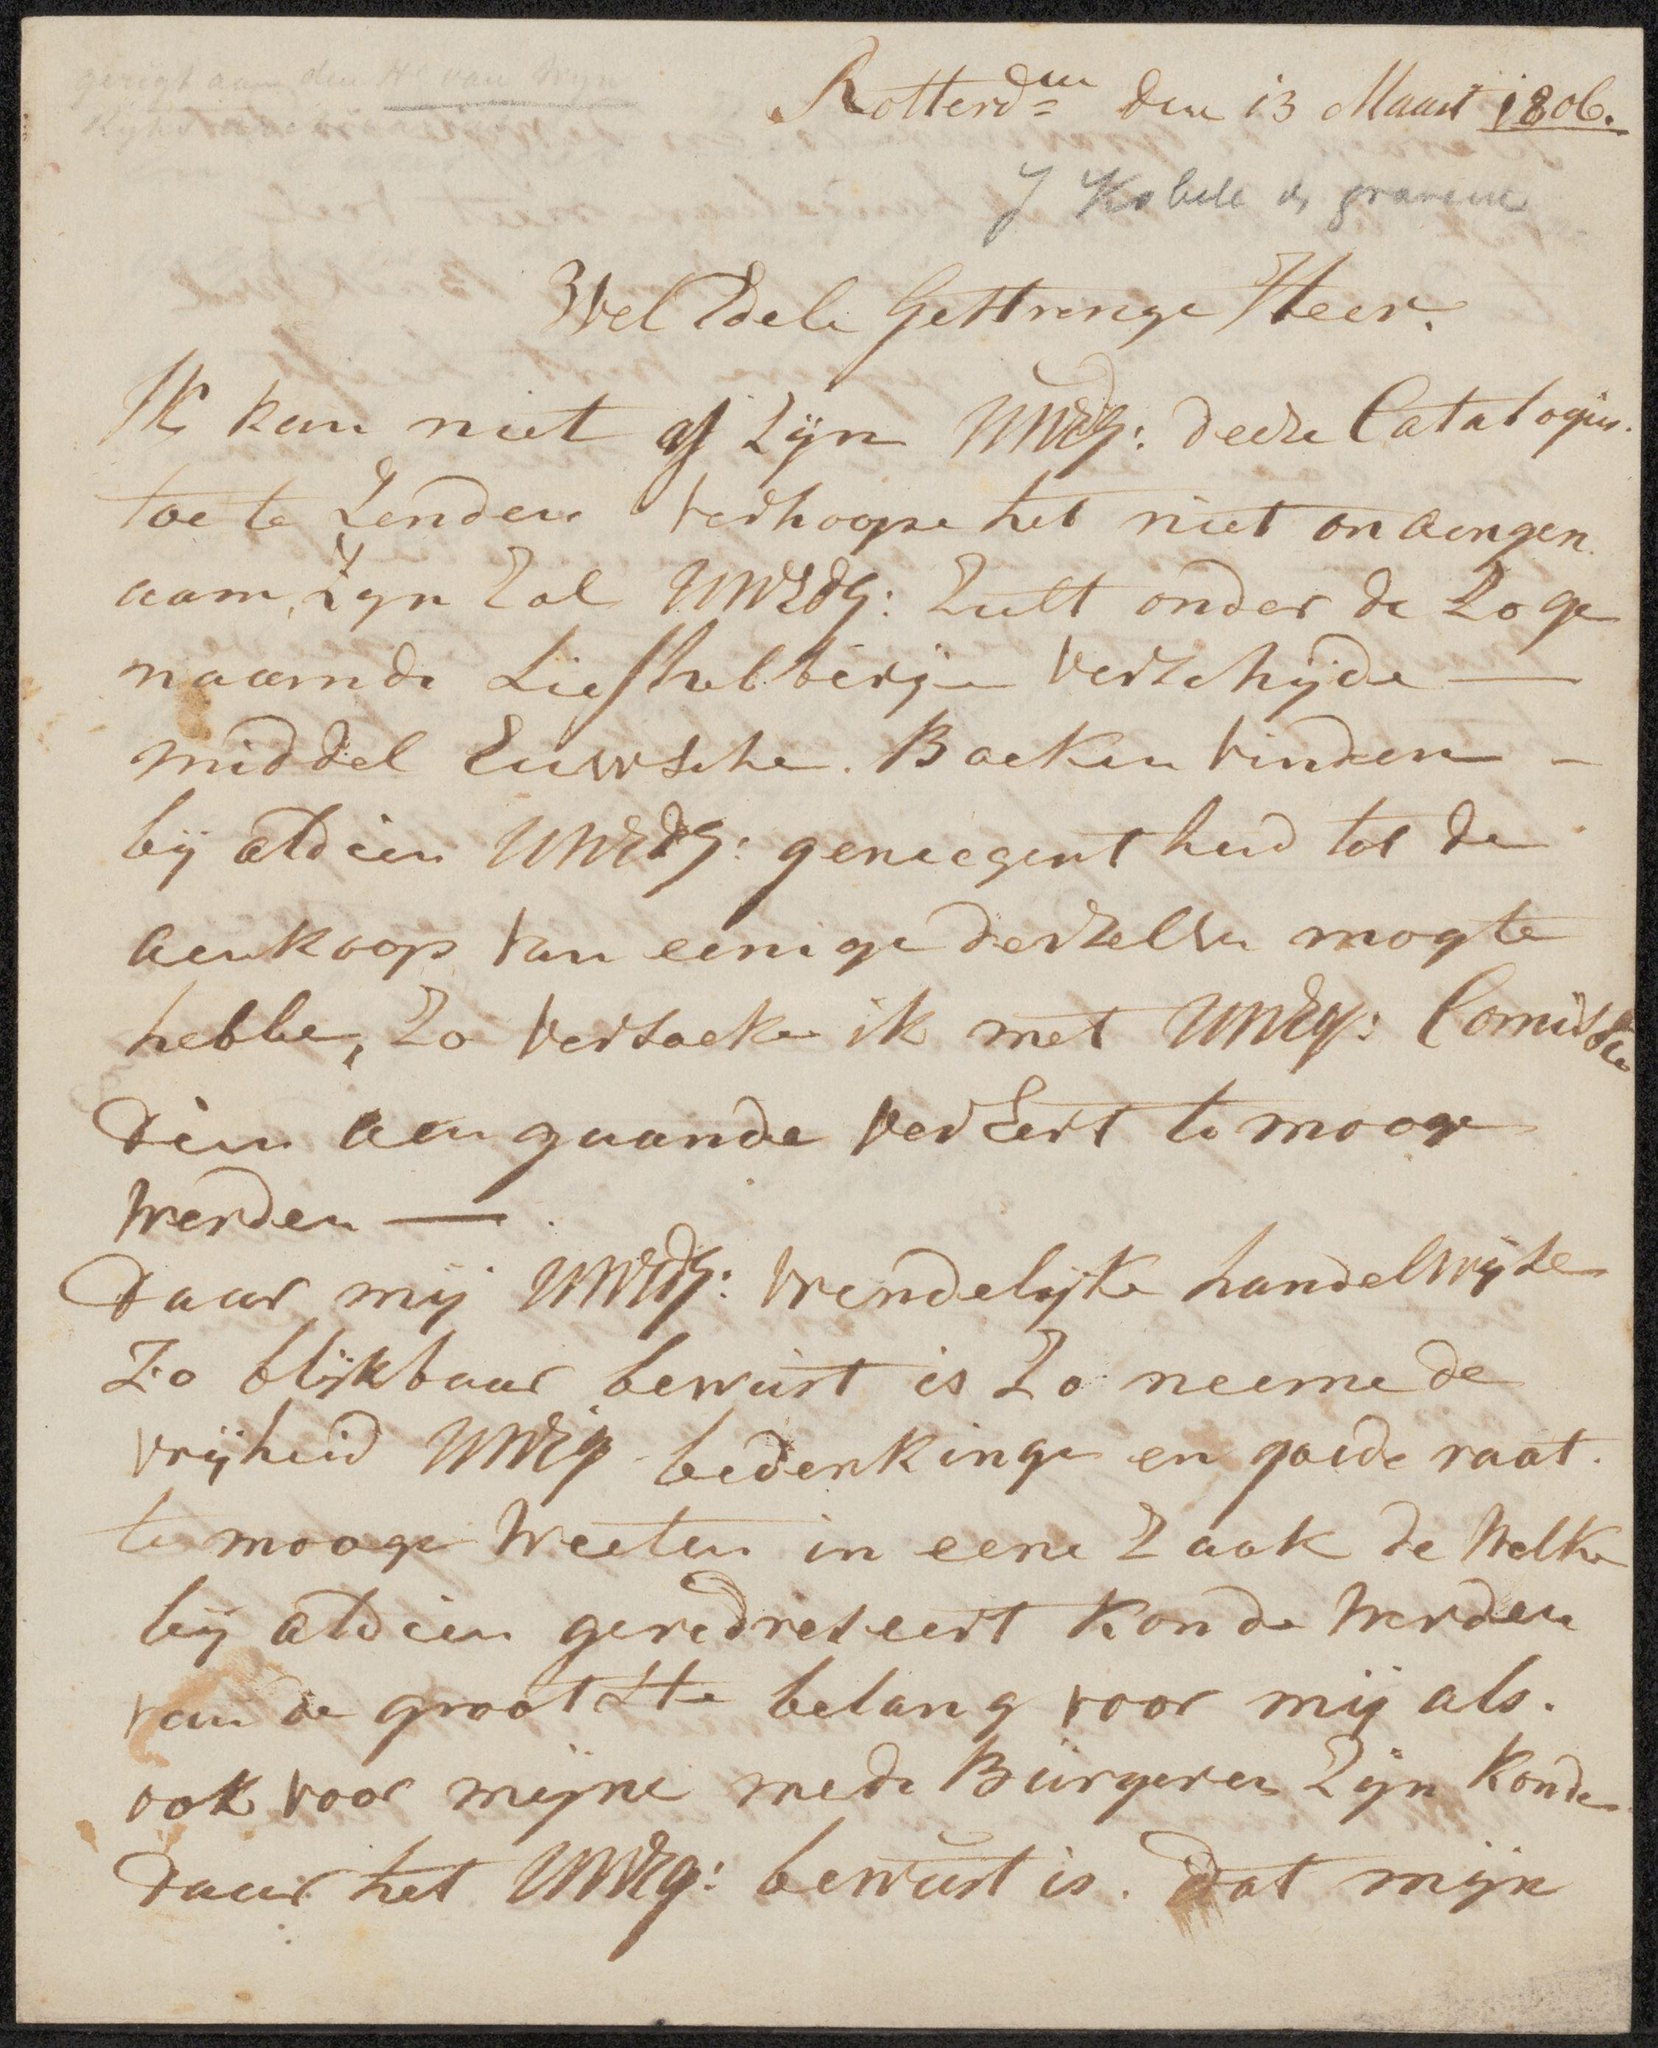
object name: letter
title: Brief aan Hendrik van Wijn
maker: jan kobell (i)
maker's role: draughtsman, print maker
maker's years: 1756-1833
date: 1806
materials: ink, paper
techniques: pen, writing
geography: rotterdam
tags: the hague, draughtsman, hendrik van wijn, the graphic arts, money, printed matter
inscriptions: watermark